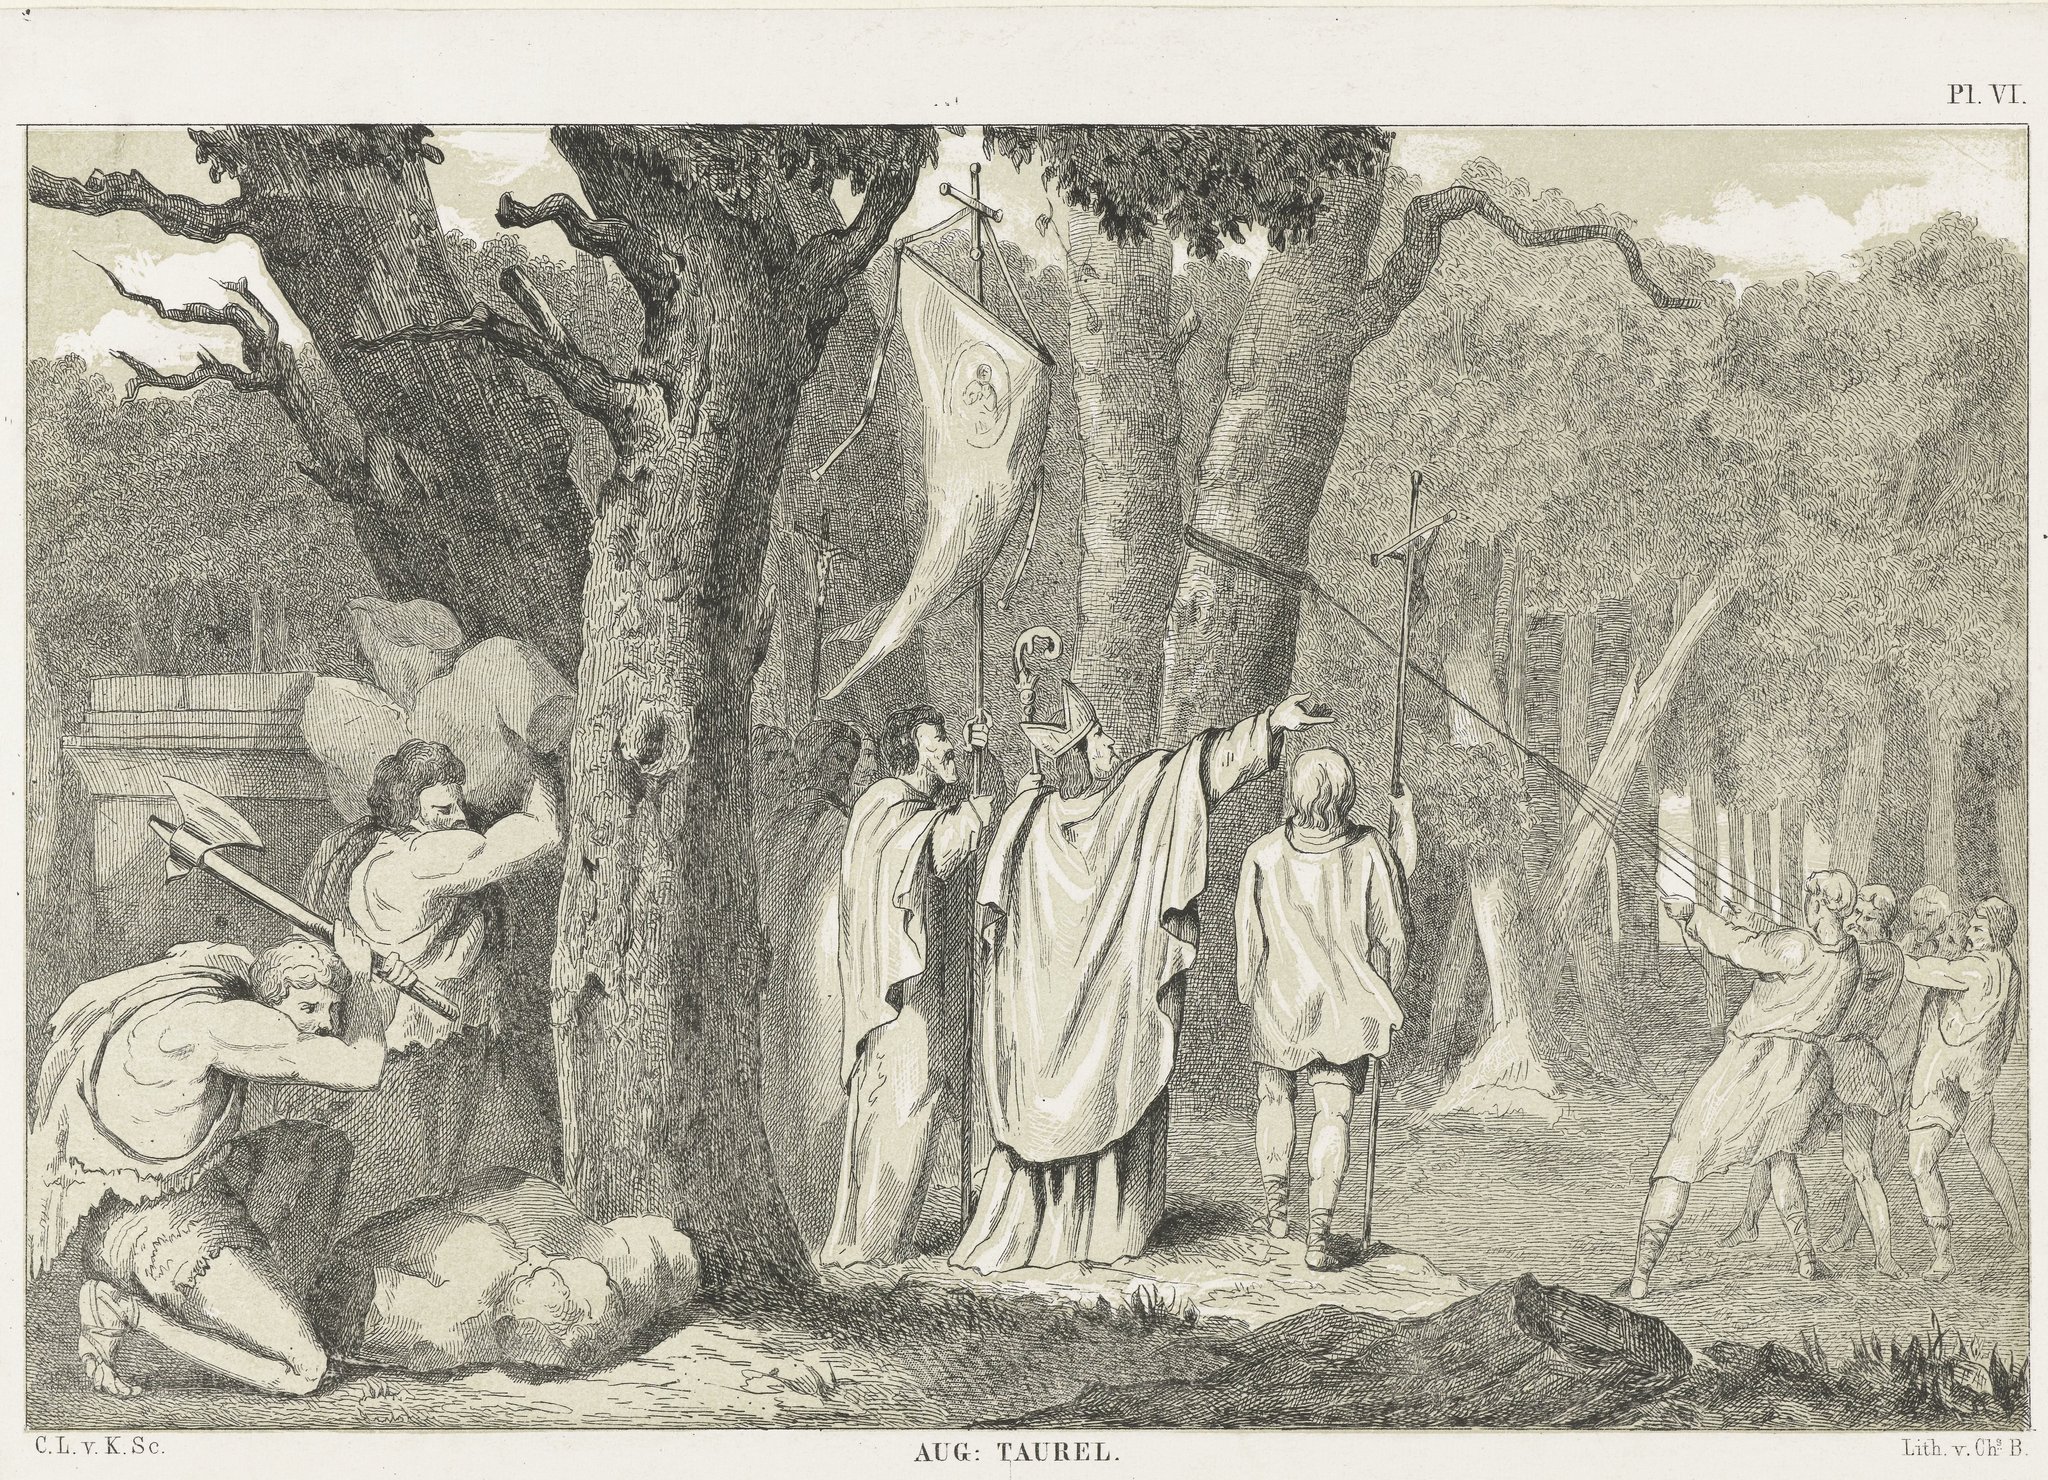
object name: history print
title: Bonifatius laat het heilige woud omhakken, ca. 740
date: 1853-1861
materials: paper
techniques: lithograph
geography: netherlands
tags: destruction of pagan idols, the martyr boniface, 'apostle of germany', and archbishop of mainz; possible attributes: axe in root of tree, book pierced by a sword, fountain (springing up from under his staff), whip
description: Illustratie voor: Jacob van Lennep, De geschiedenis des vaderlands in schetsen en afbeeldingen, Binger, Amsterdam 1855-1861, 8 delen, pl. VI.